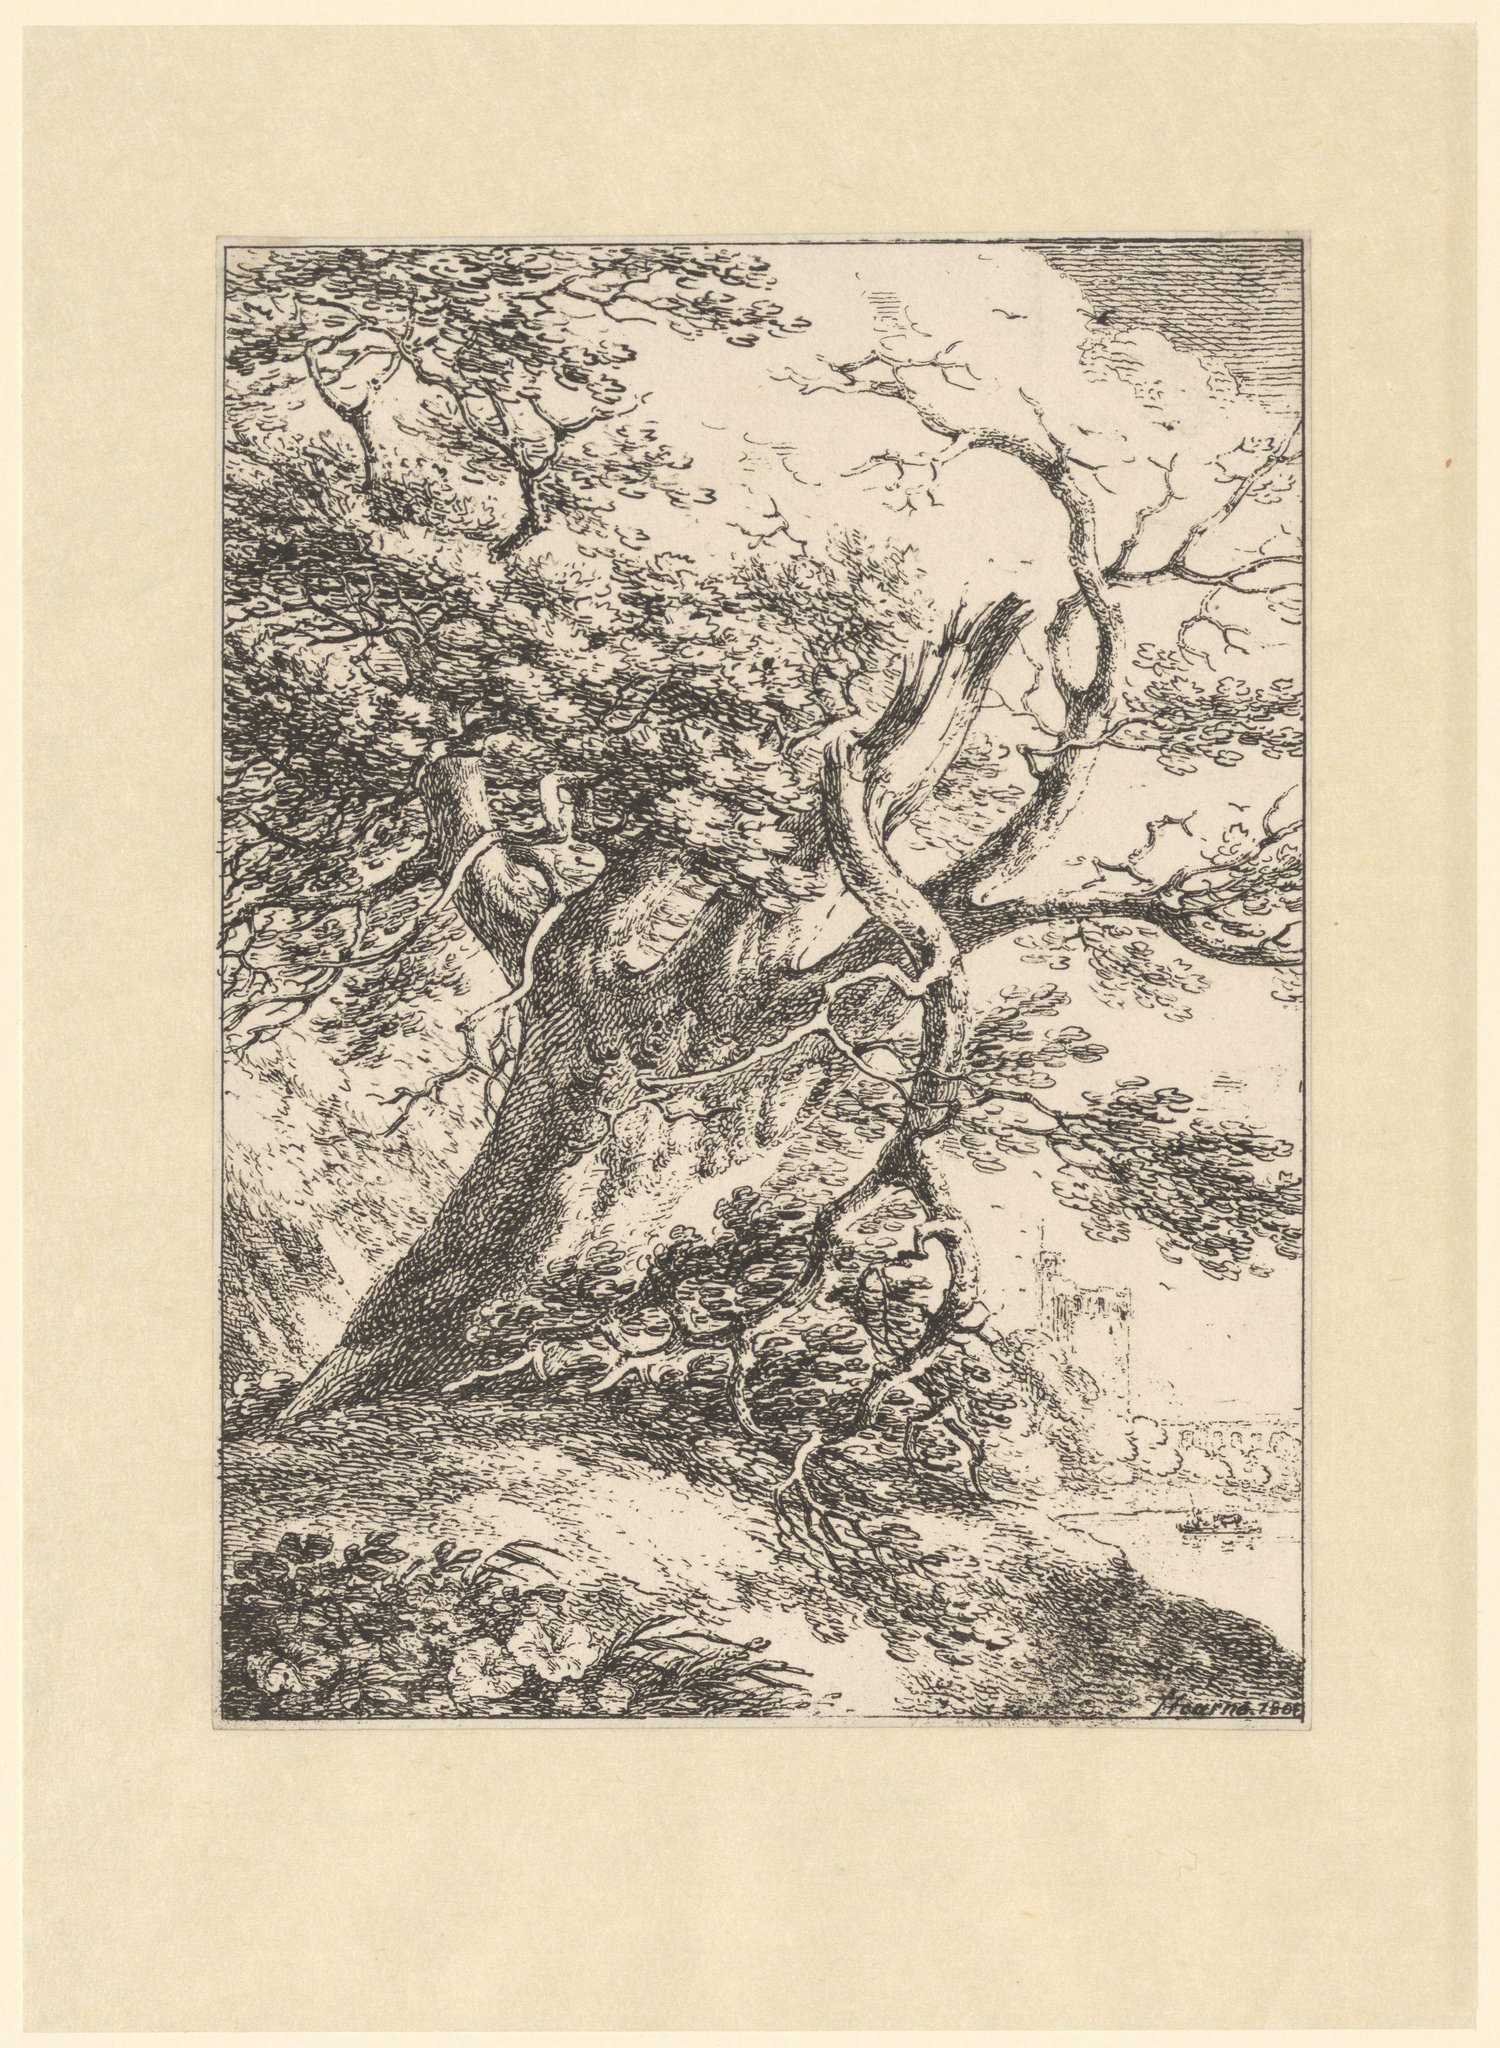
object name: print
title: Boom met afgebroken tak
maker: thomas hearne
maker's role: draughtsman, print maker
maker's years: 1744-1817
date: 1803-1807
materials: paper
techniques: lithograph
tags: trees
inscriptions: collector's mark: Lugt 2228, collector's mark: Lugt 2760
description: Deze prent behoort tot de serie 'Specimens of polyautography'. Deze serie is een van de vroegste reeksen lithografieën in Groot-Brittannië en de eerste editie werd uitgegeven door Philipp André in 1803. Deze prent behoort waarschijnlijk tot de tweede editie, uitgegeven door Georg Jacob Vollweiler in 1806-1807. De serie is door Vollweiler uitgegeven in zes delen met zes lithografieën.